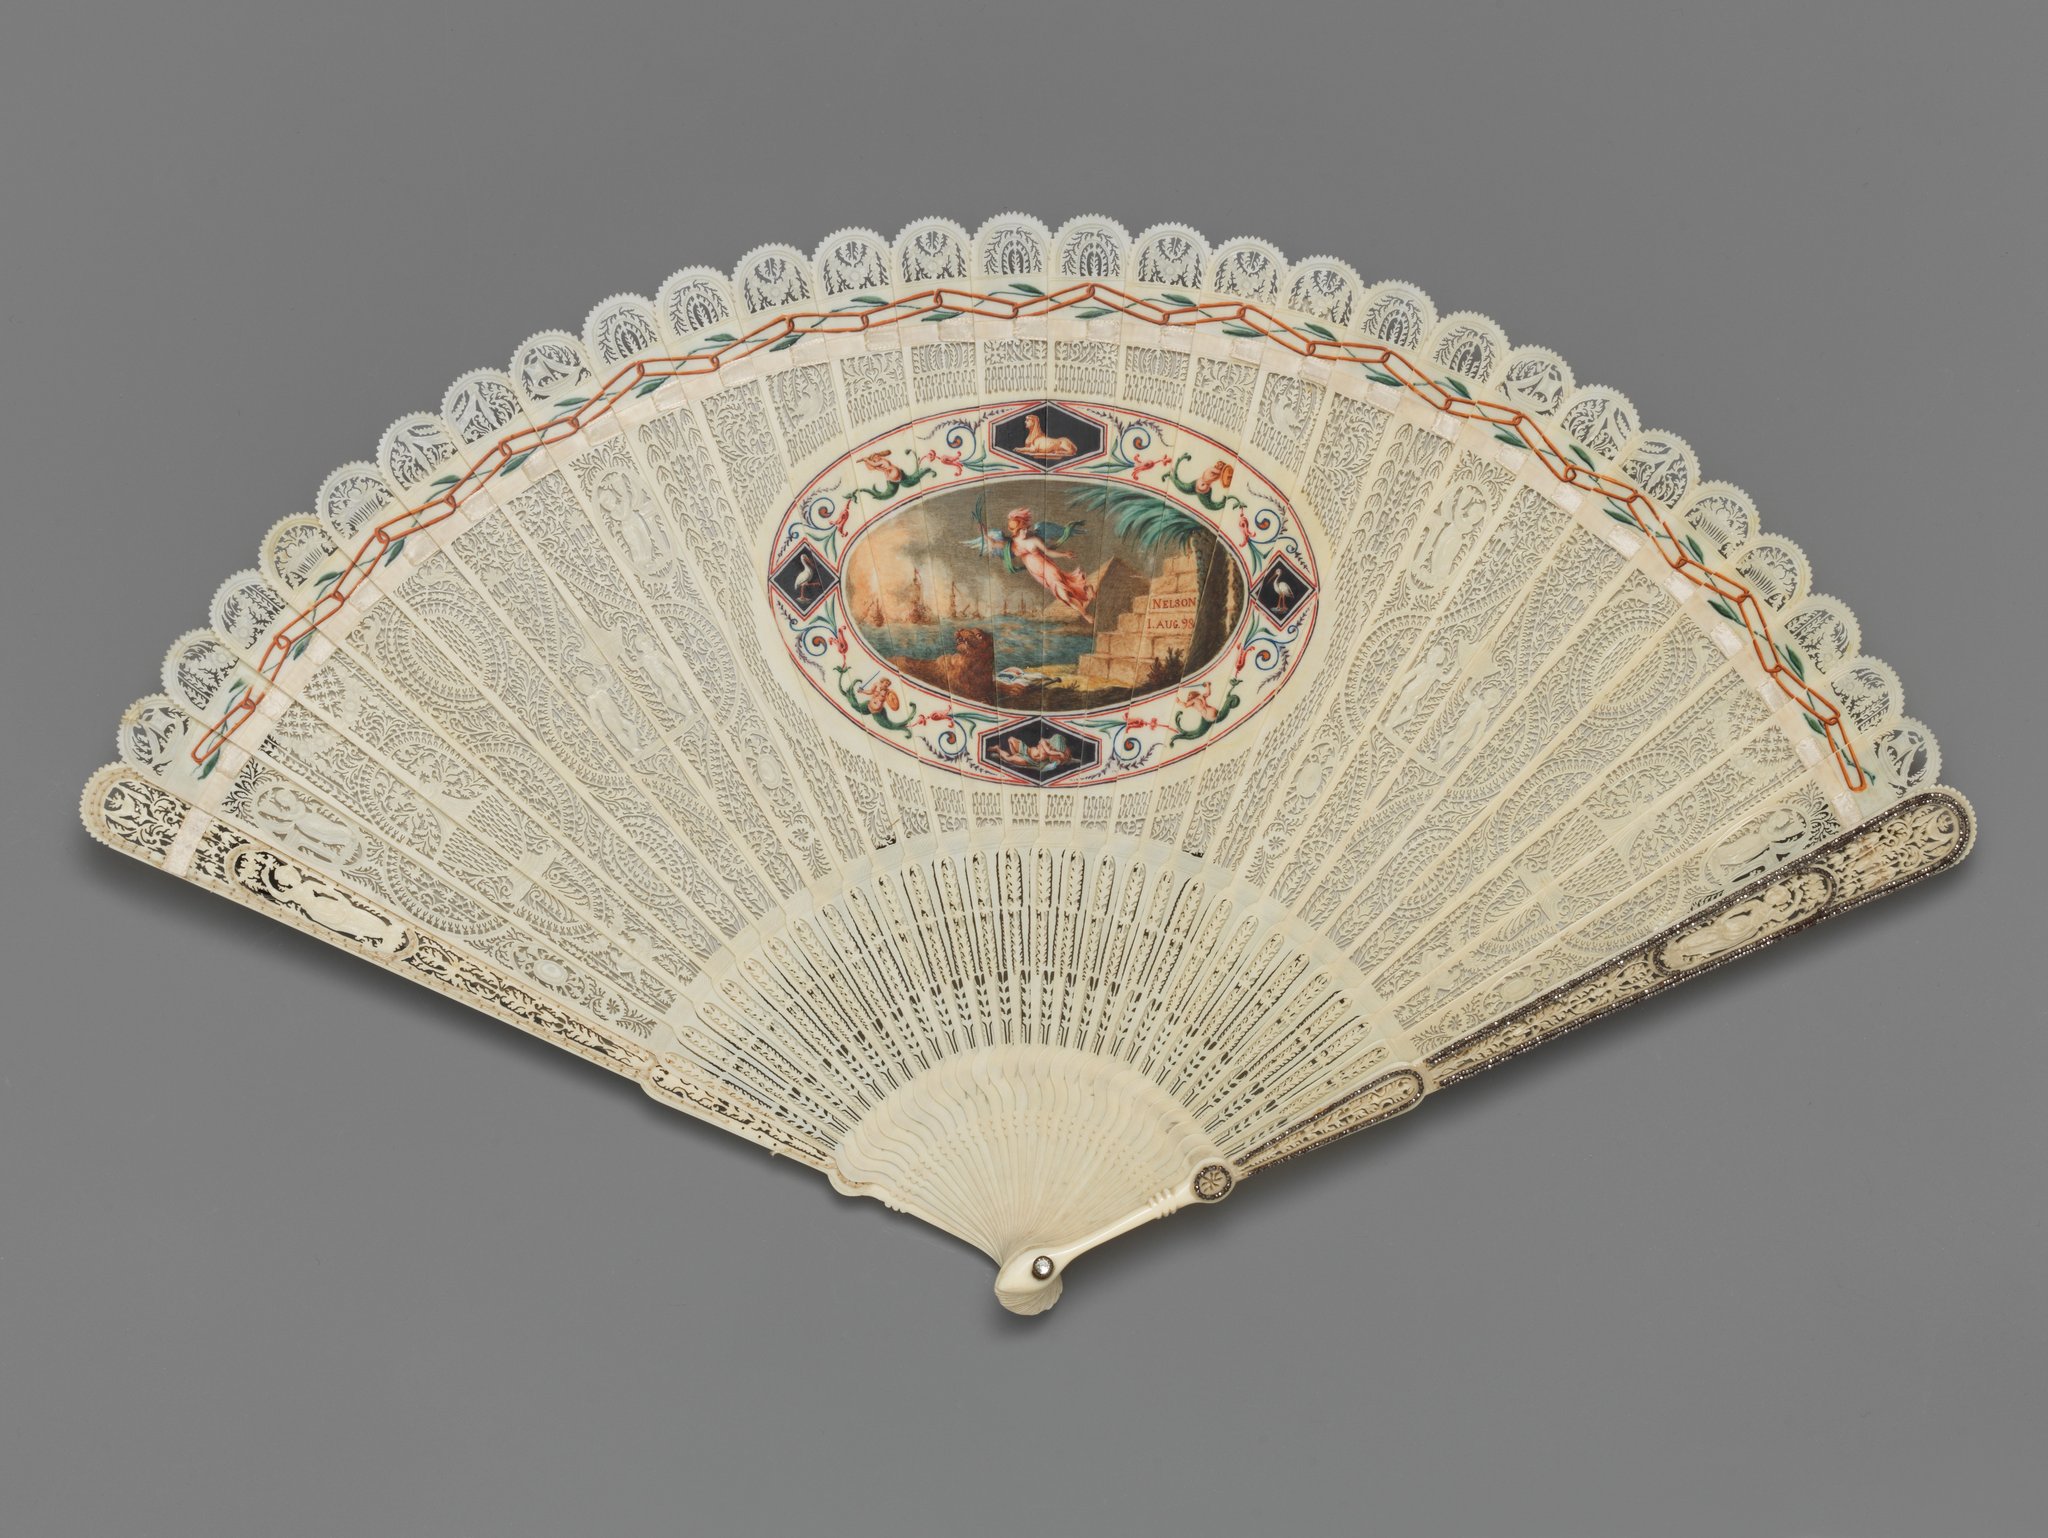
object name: fan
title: Brisé fan depicting The Battle of the Nile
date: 1798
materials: glass, ivory, ribbon, silk, steel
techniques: carving, painting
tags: birds,sphinx,lions